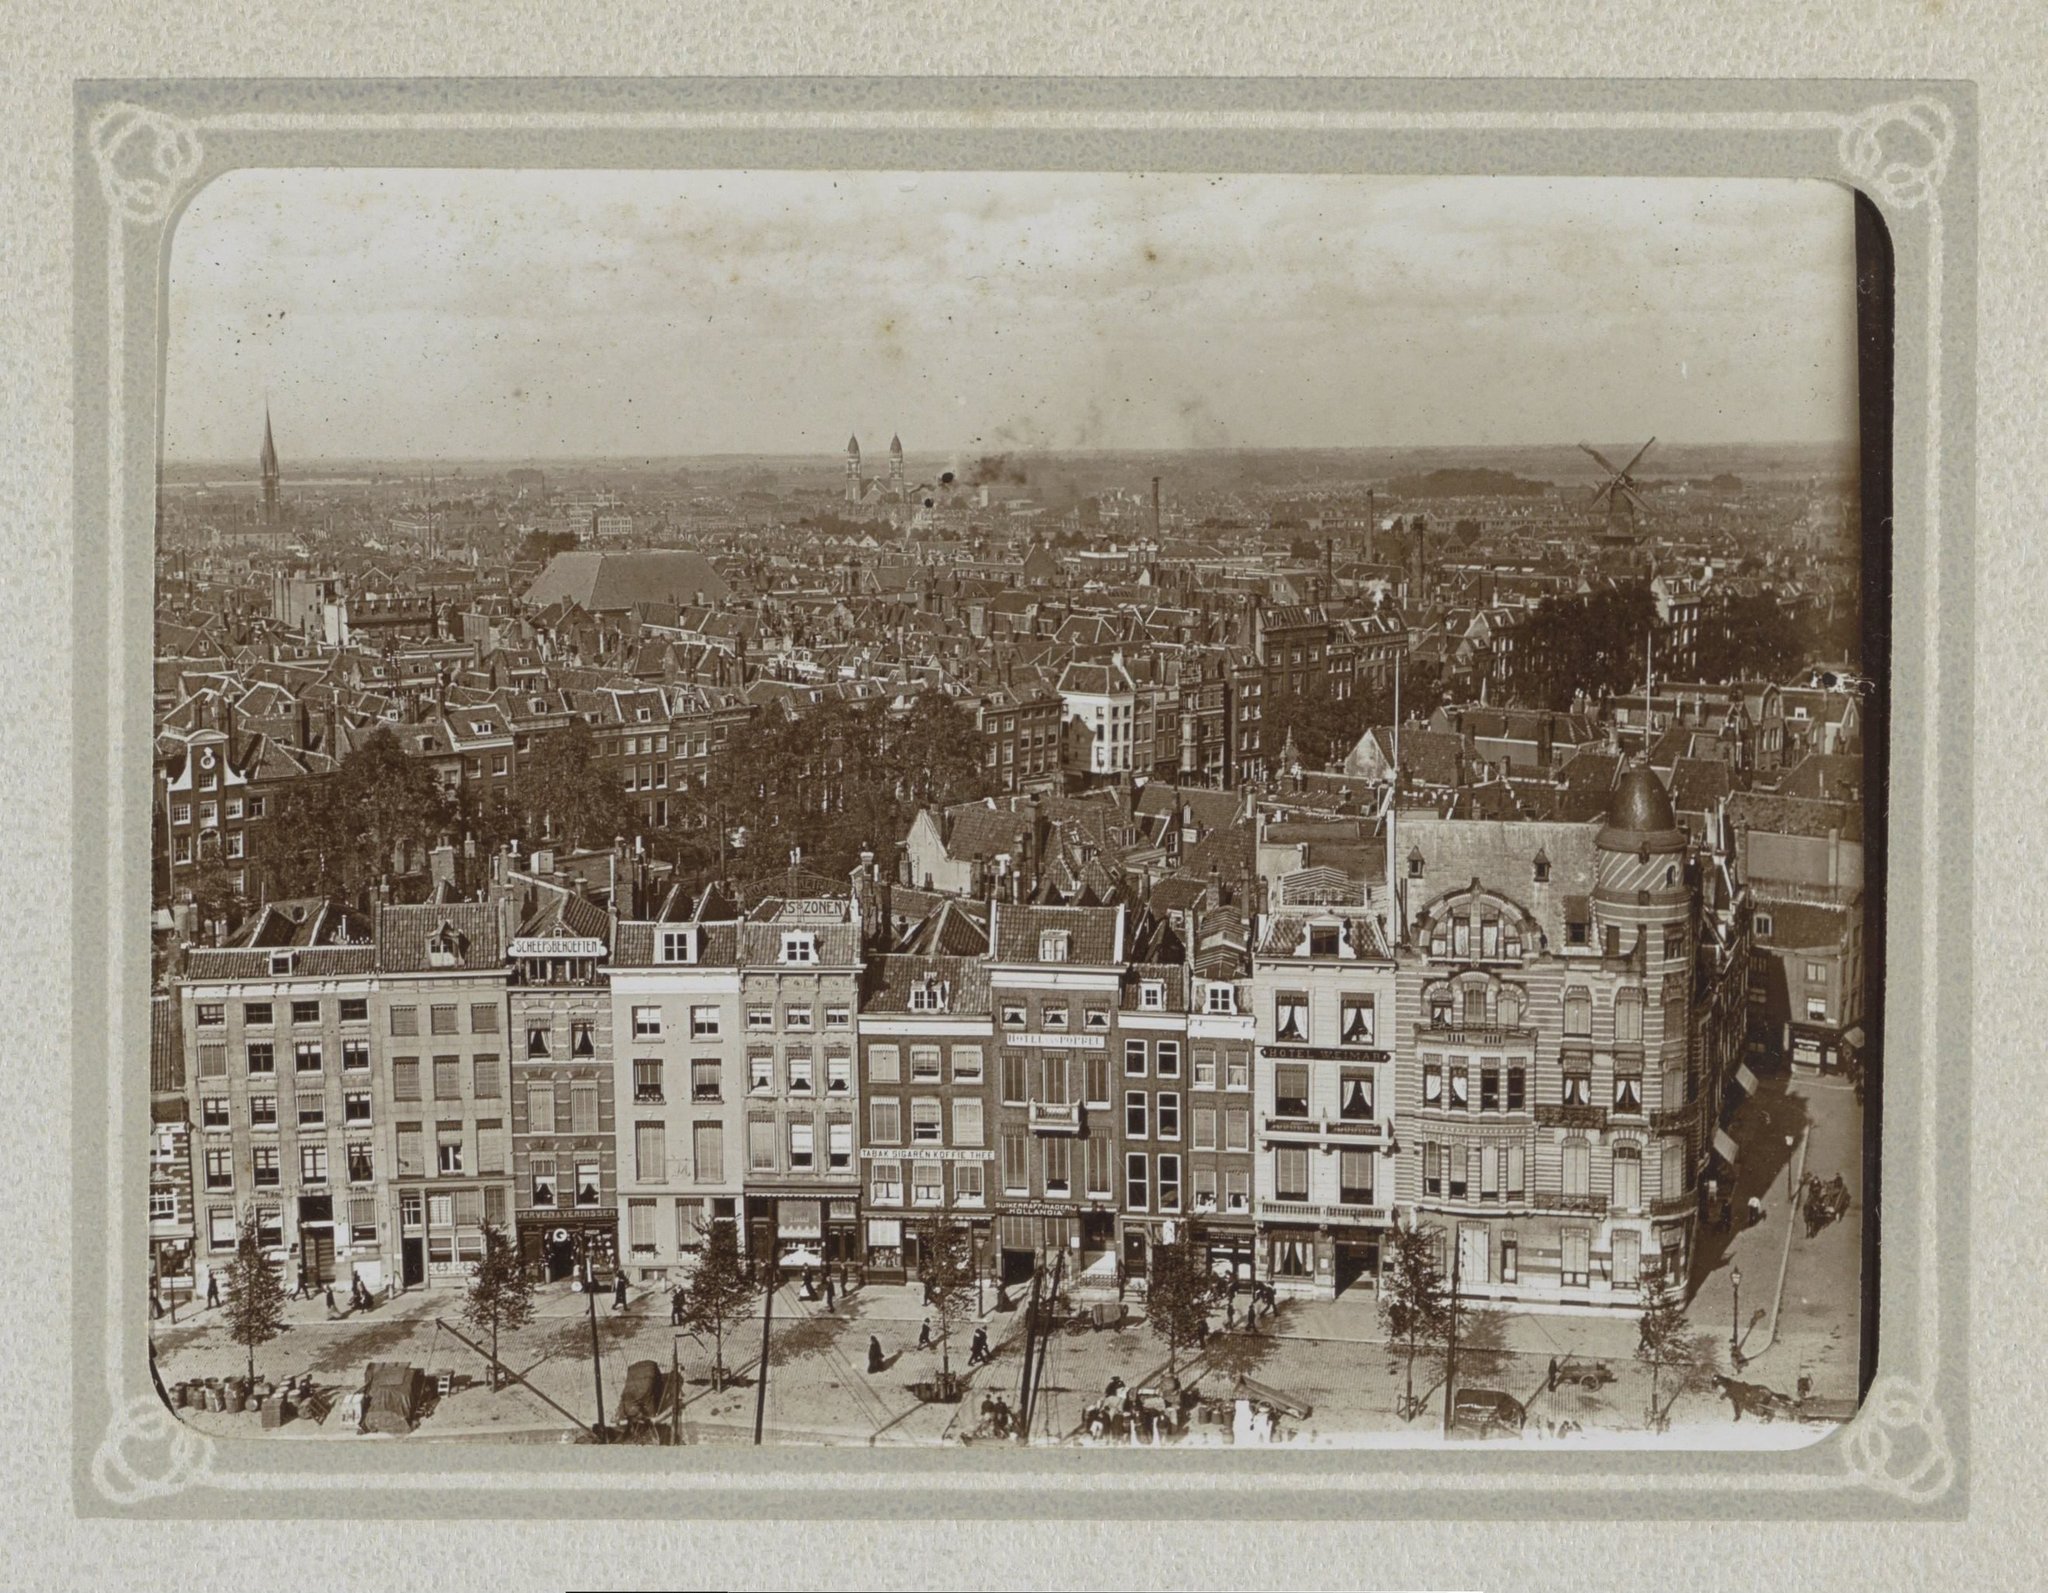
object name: photograph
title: Gezicht op Rotterdam, vooraan de Spaanse kade, centraal op de achtergrond de Koninginnekerk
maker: folkert idzes de jong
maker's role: architect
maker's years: 1877-1929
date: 1905-1907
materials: photographic support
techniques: collodion silver print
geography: rotterdam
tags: city-view, and landscape with man-made constructions, pier, quay, wharf, parts of church exterior and annexes: tower, rotterdam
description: Onderdeel van Topografisch album van Nederlandse dorpen en steden 1905.